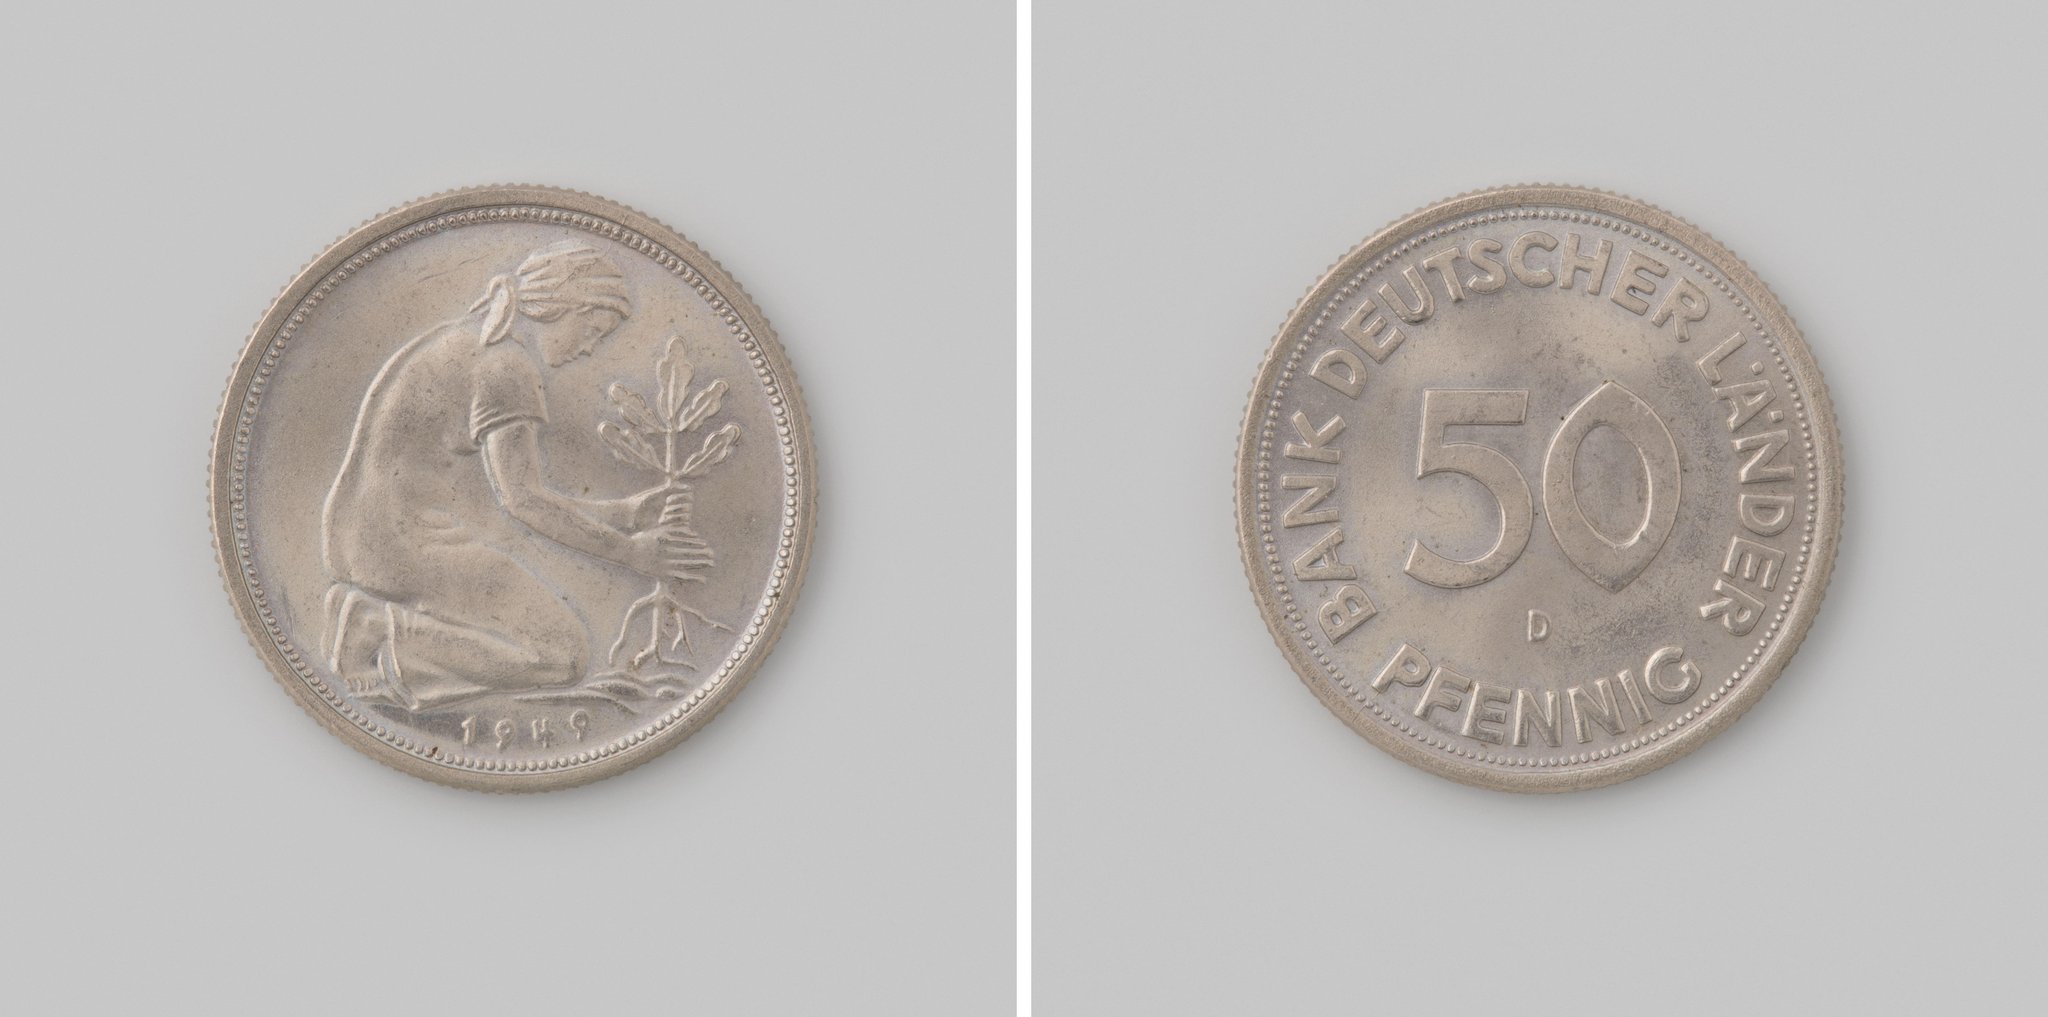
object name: vijftig pfennig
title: Duitsland, Deutsche Länder, 50 Pfennig, 1949 D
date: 1949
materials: nickel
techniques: striking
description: Nikkelen munt. Voorzijde: zittende vrouw die boom plant. Jaartal onderaan. Keerzijde: waarde-aanduiding in twee regels, waartussen letter D. Geslagen in Mùnchen. Kartelrand.